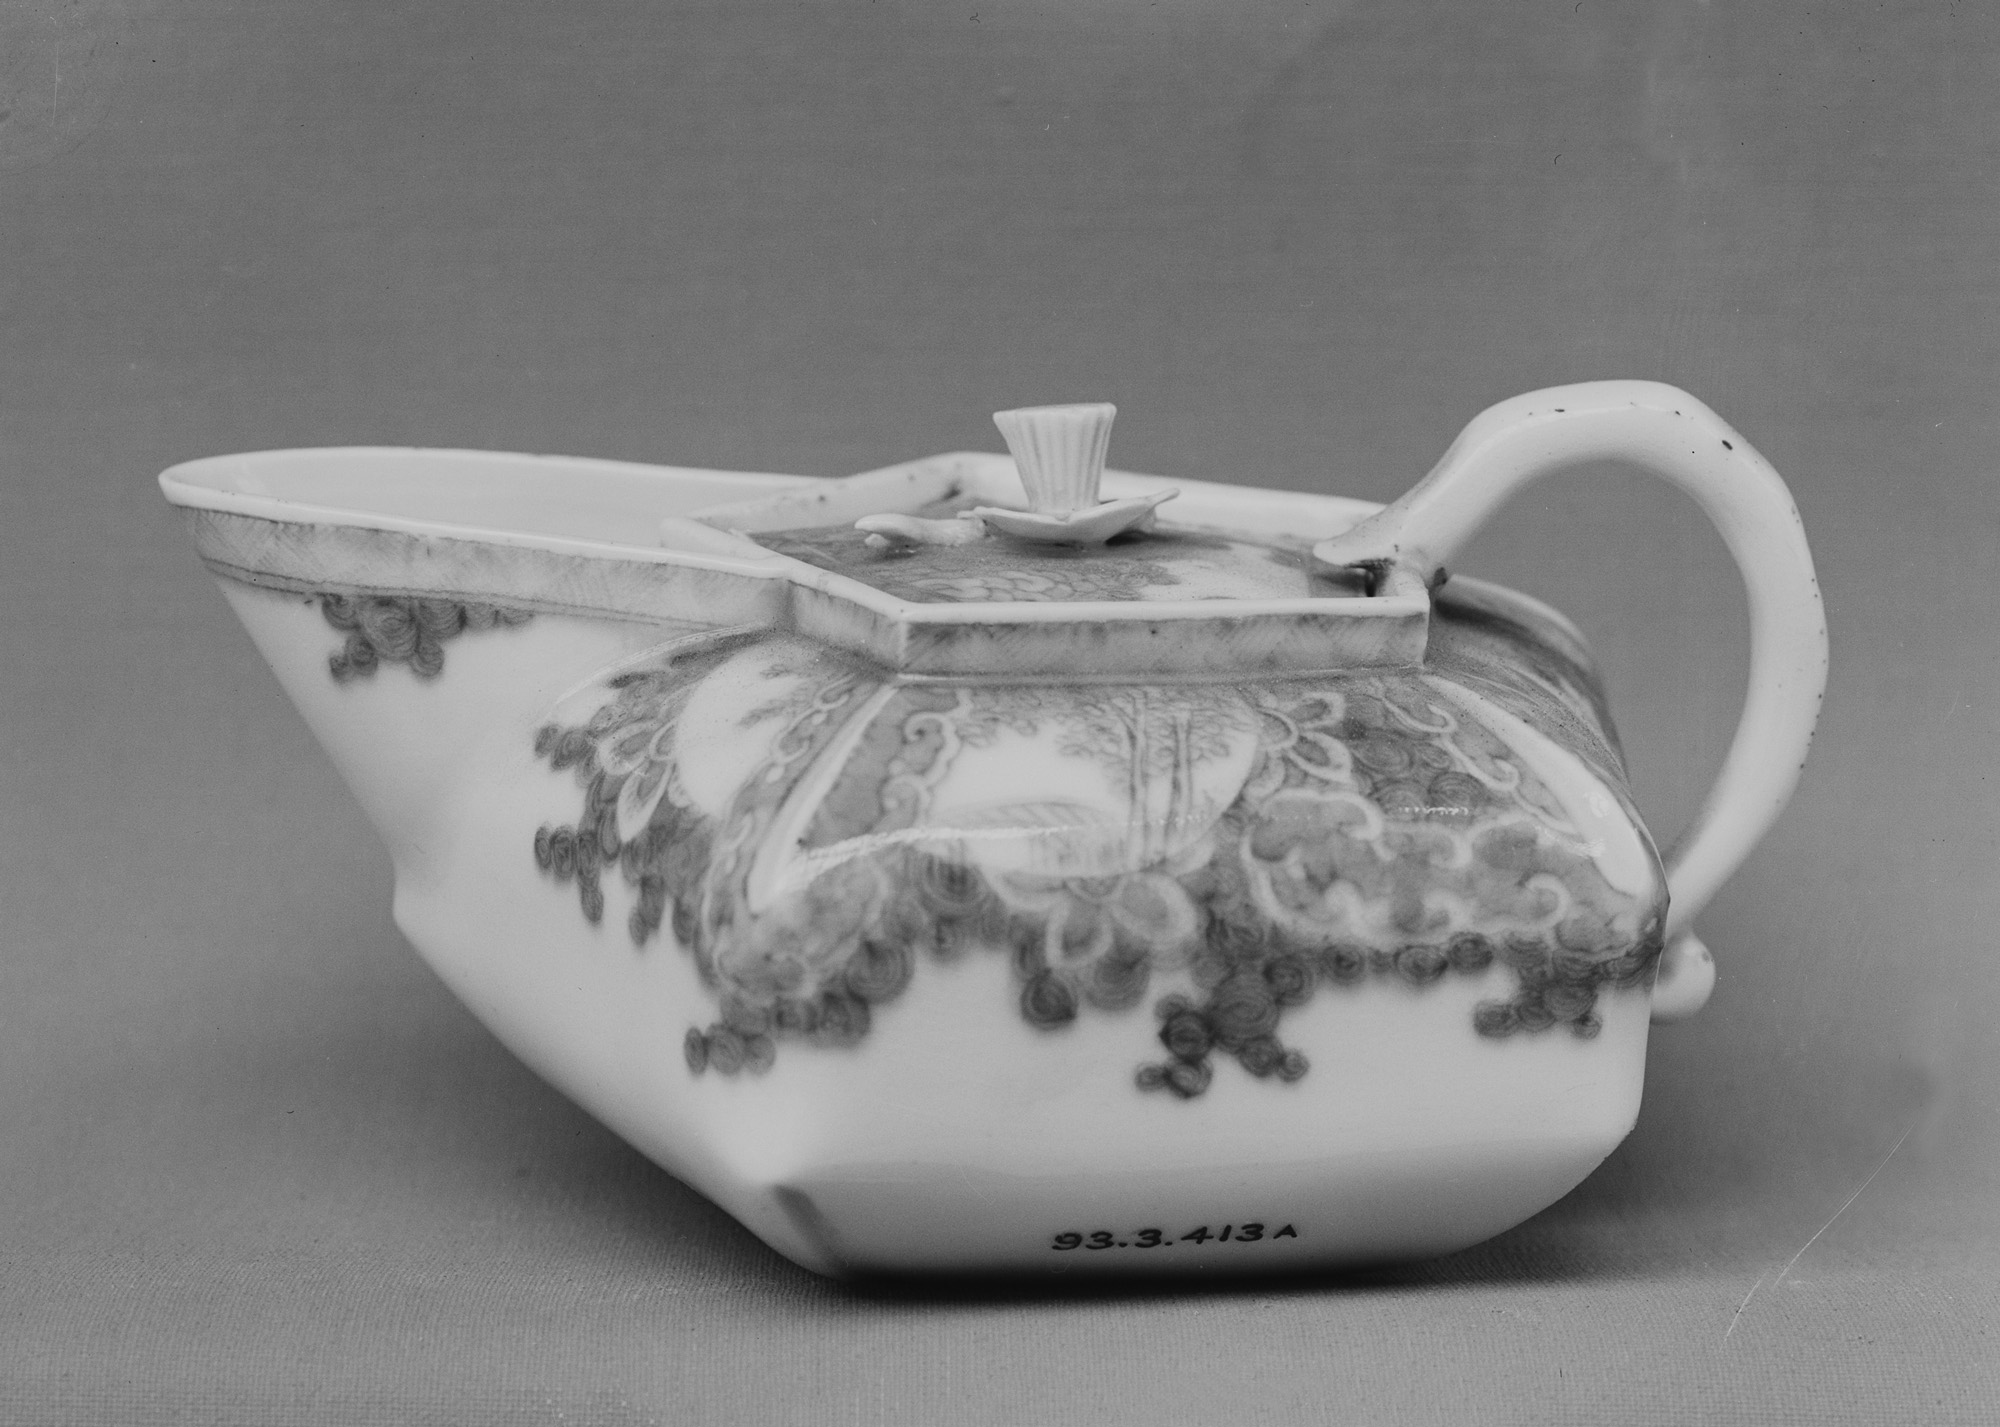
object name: teapot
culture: japanese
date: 1800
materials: glaze, porcelain